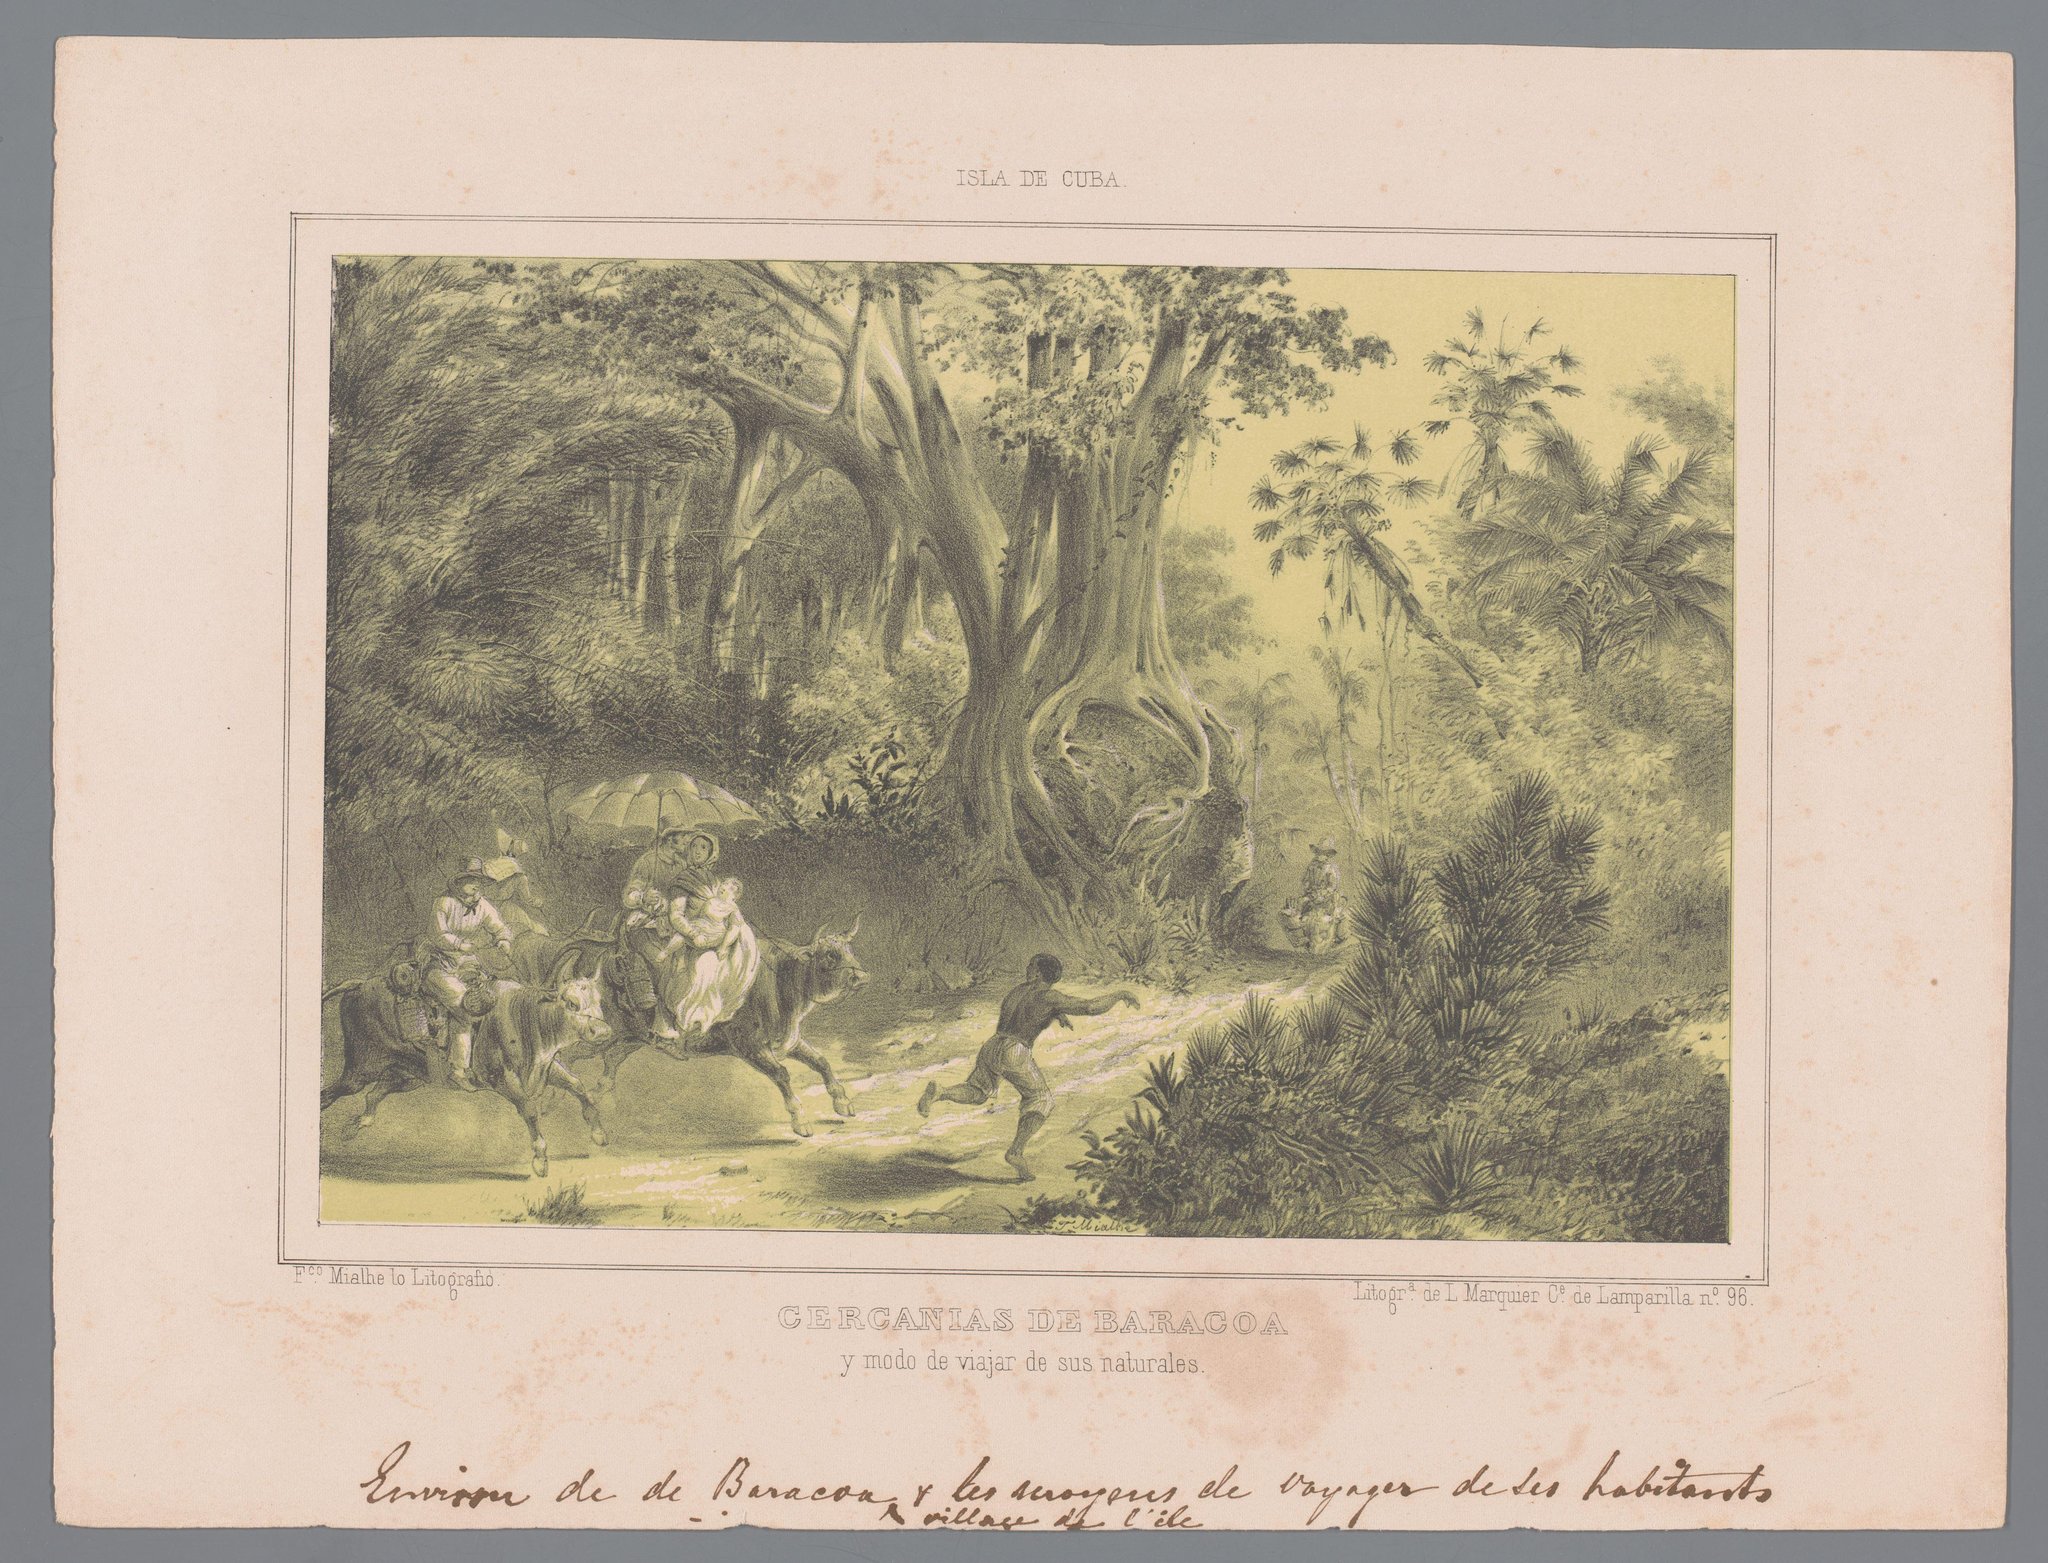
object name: print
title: Gezicht op Baracoa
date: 1848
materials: paper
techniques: tone lithography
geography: cuba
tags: traffic and transport, forest, wood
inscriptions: collector's mark: Lugt 2228